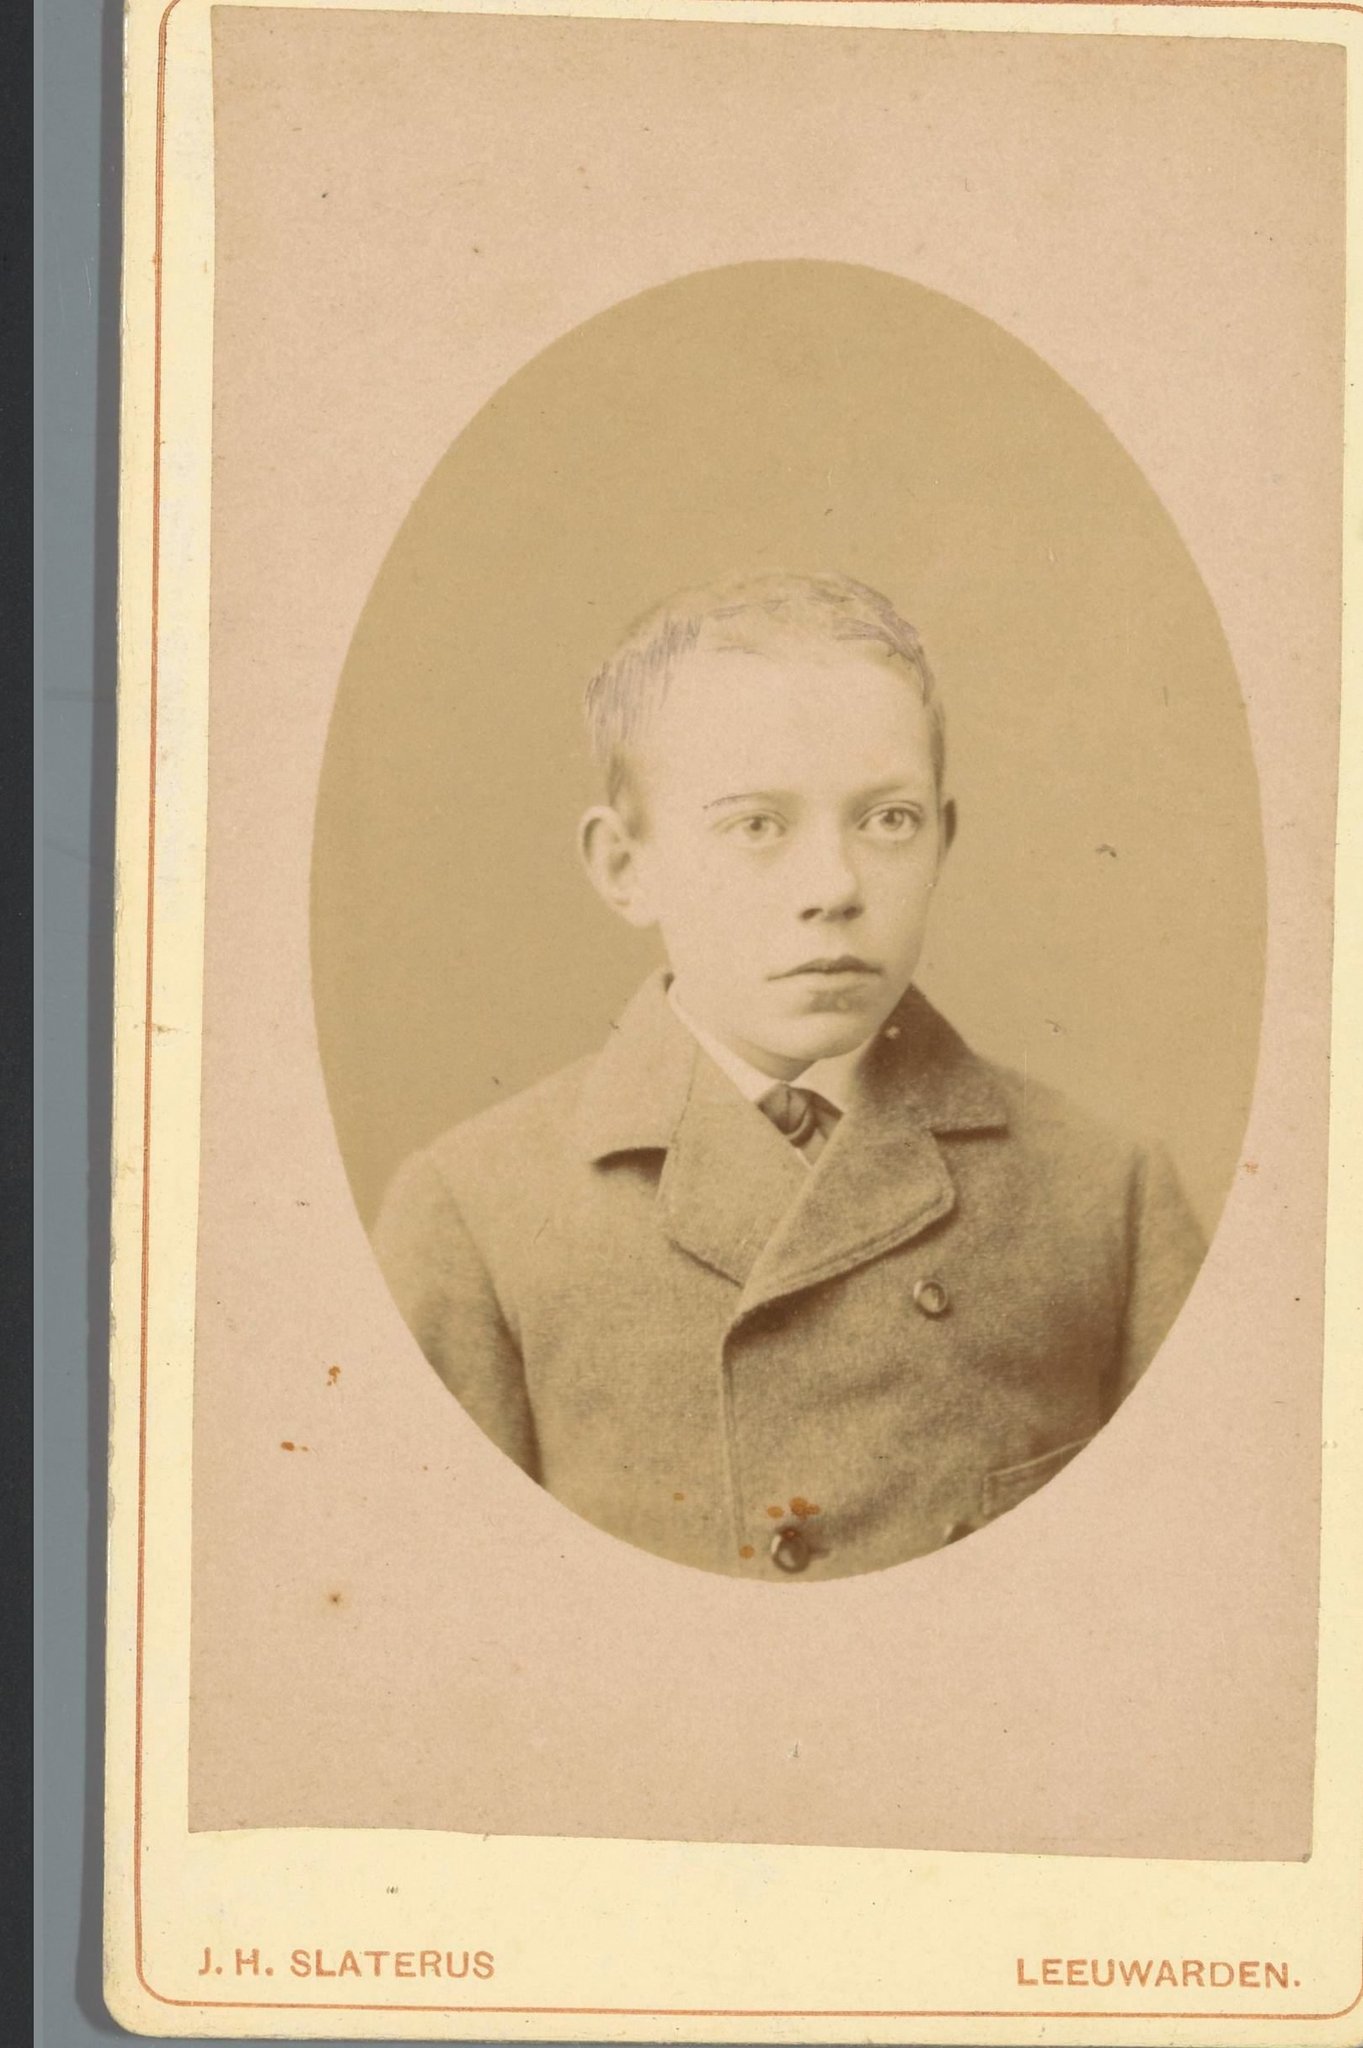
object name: carte de visite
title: Portret van een onbekende jongen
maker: idanus hendrikus slaterus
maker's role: fotograaf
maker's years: 1846-1921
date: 1873-1892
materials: cardboard, paper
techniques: albumen print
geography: leeuwarden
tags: boy (child between toddler and youth), historical persons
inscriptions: inscription: ‘I. H. Slaterus/ Photograaf/ Leeuwarden/ Weerdt K13./ hoek Bagijnestraat./ Van elk portret kunnen vergrootingen gemaakt worden.’